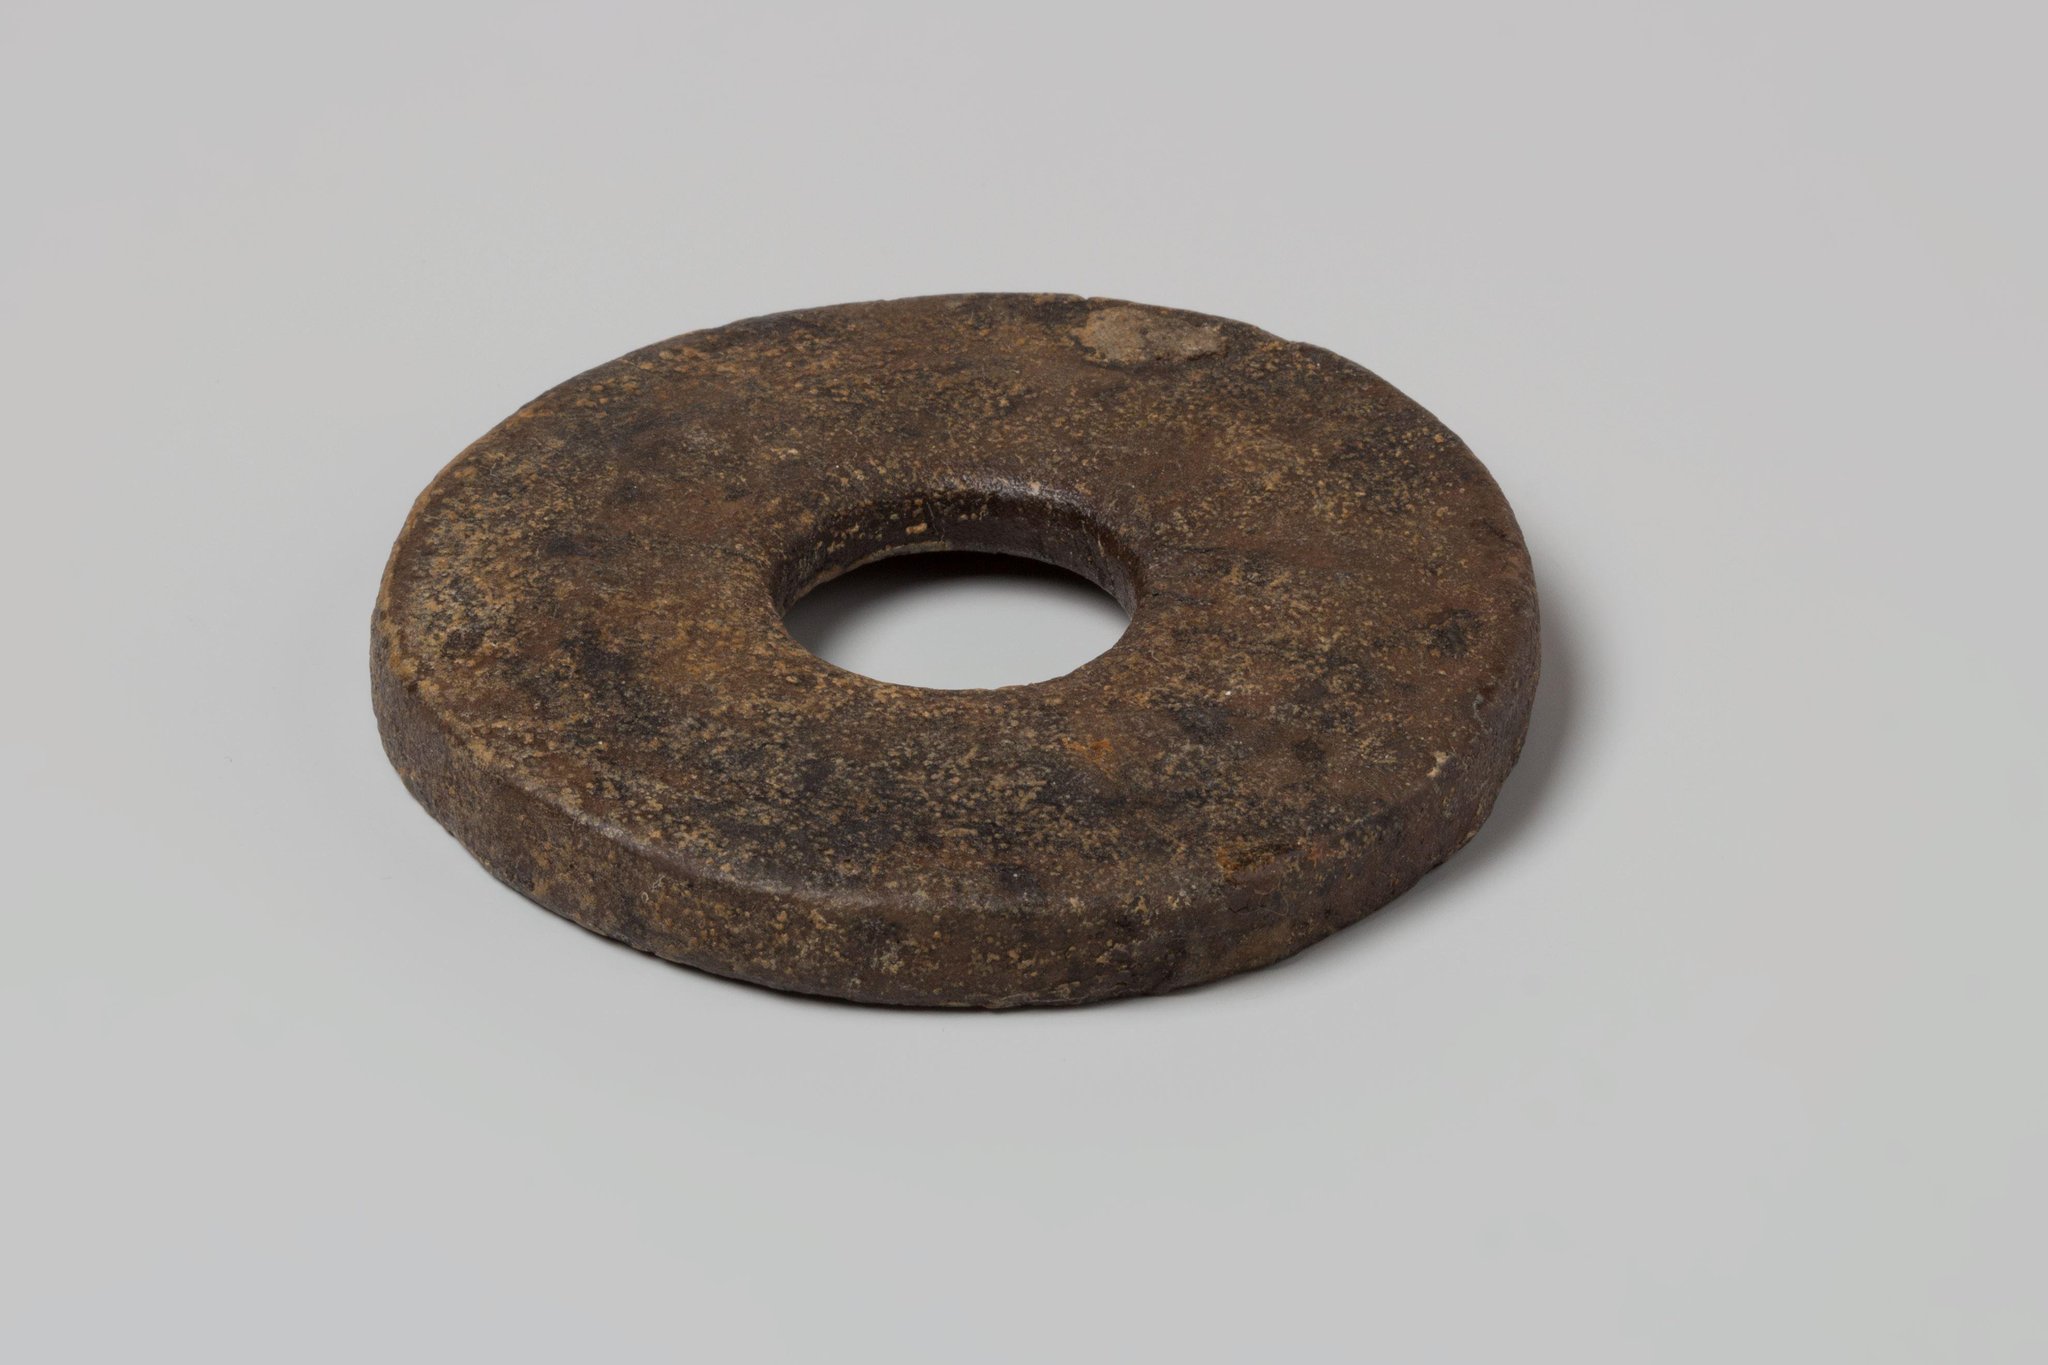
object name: disk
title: Schijf uit V.O.C.-schip de 'Witte Leeuw'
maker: Anonymous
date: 1613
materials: wood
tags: verenigde oostindische compagnie, sint-helena